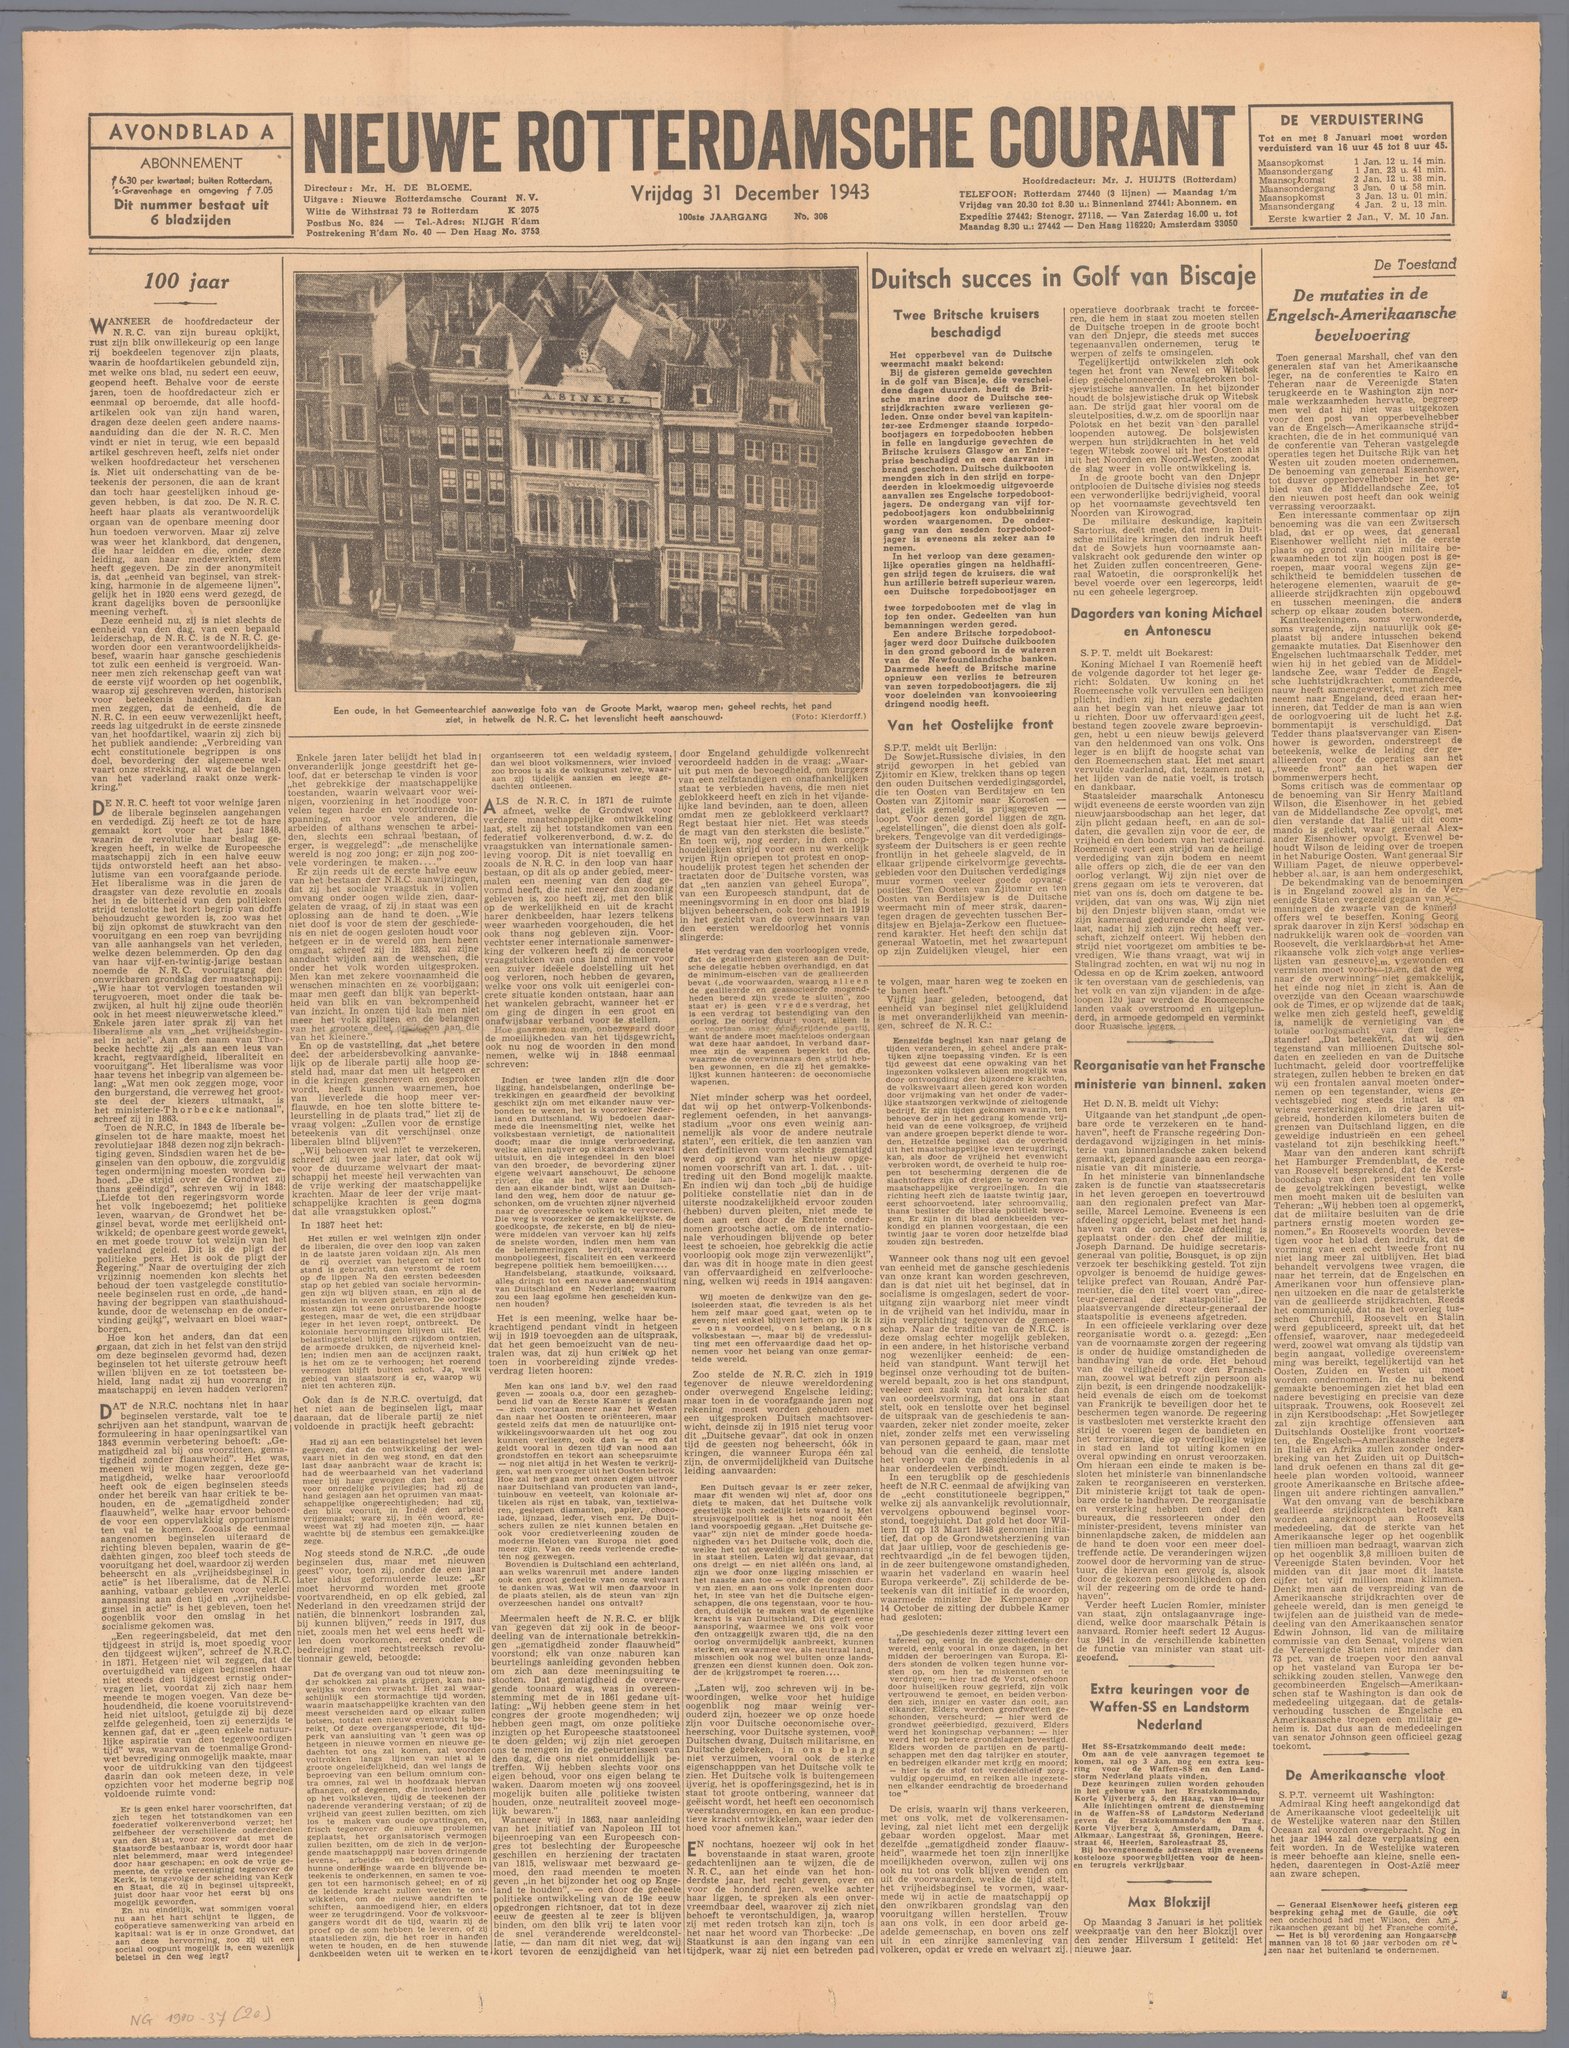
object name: newspaper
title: Nieuwe Rotterdamsche Courant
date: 1943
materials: paper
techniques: printing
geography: rotterdam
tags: netherlands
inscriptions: date